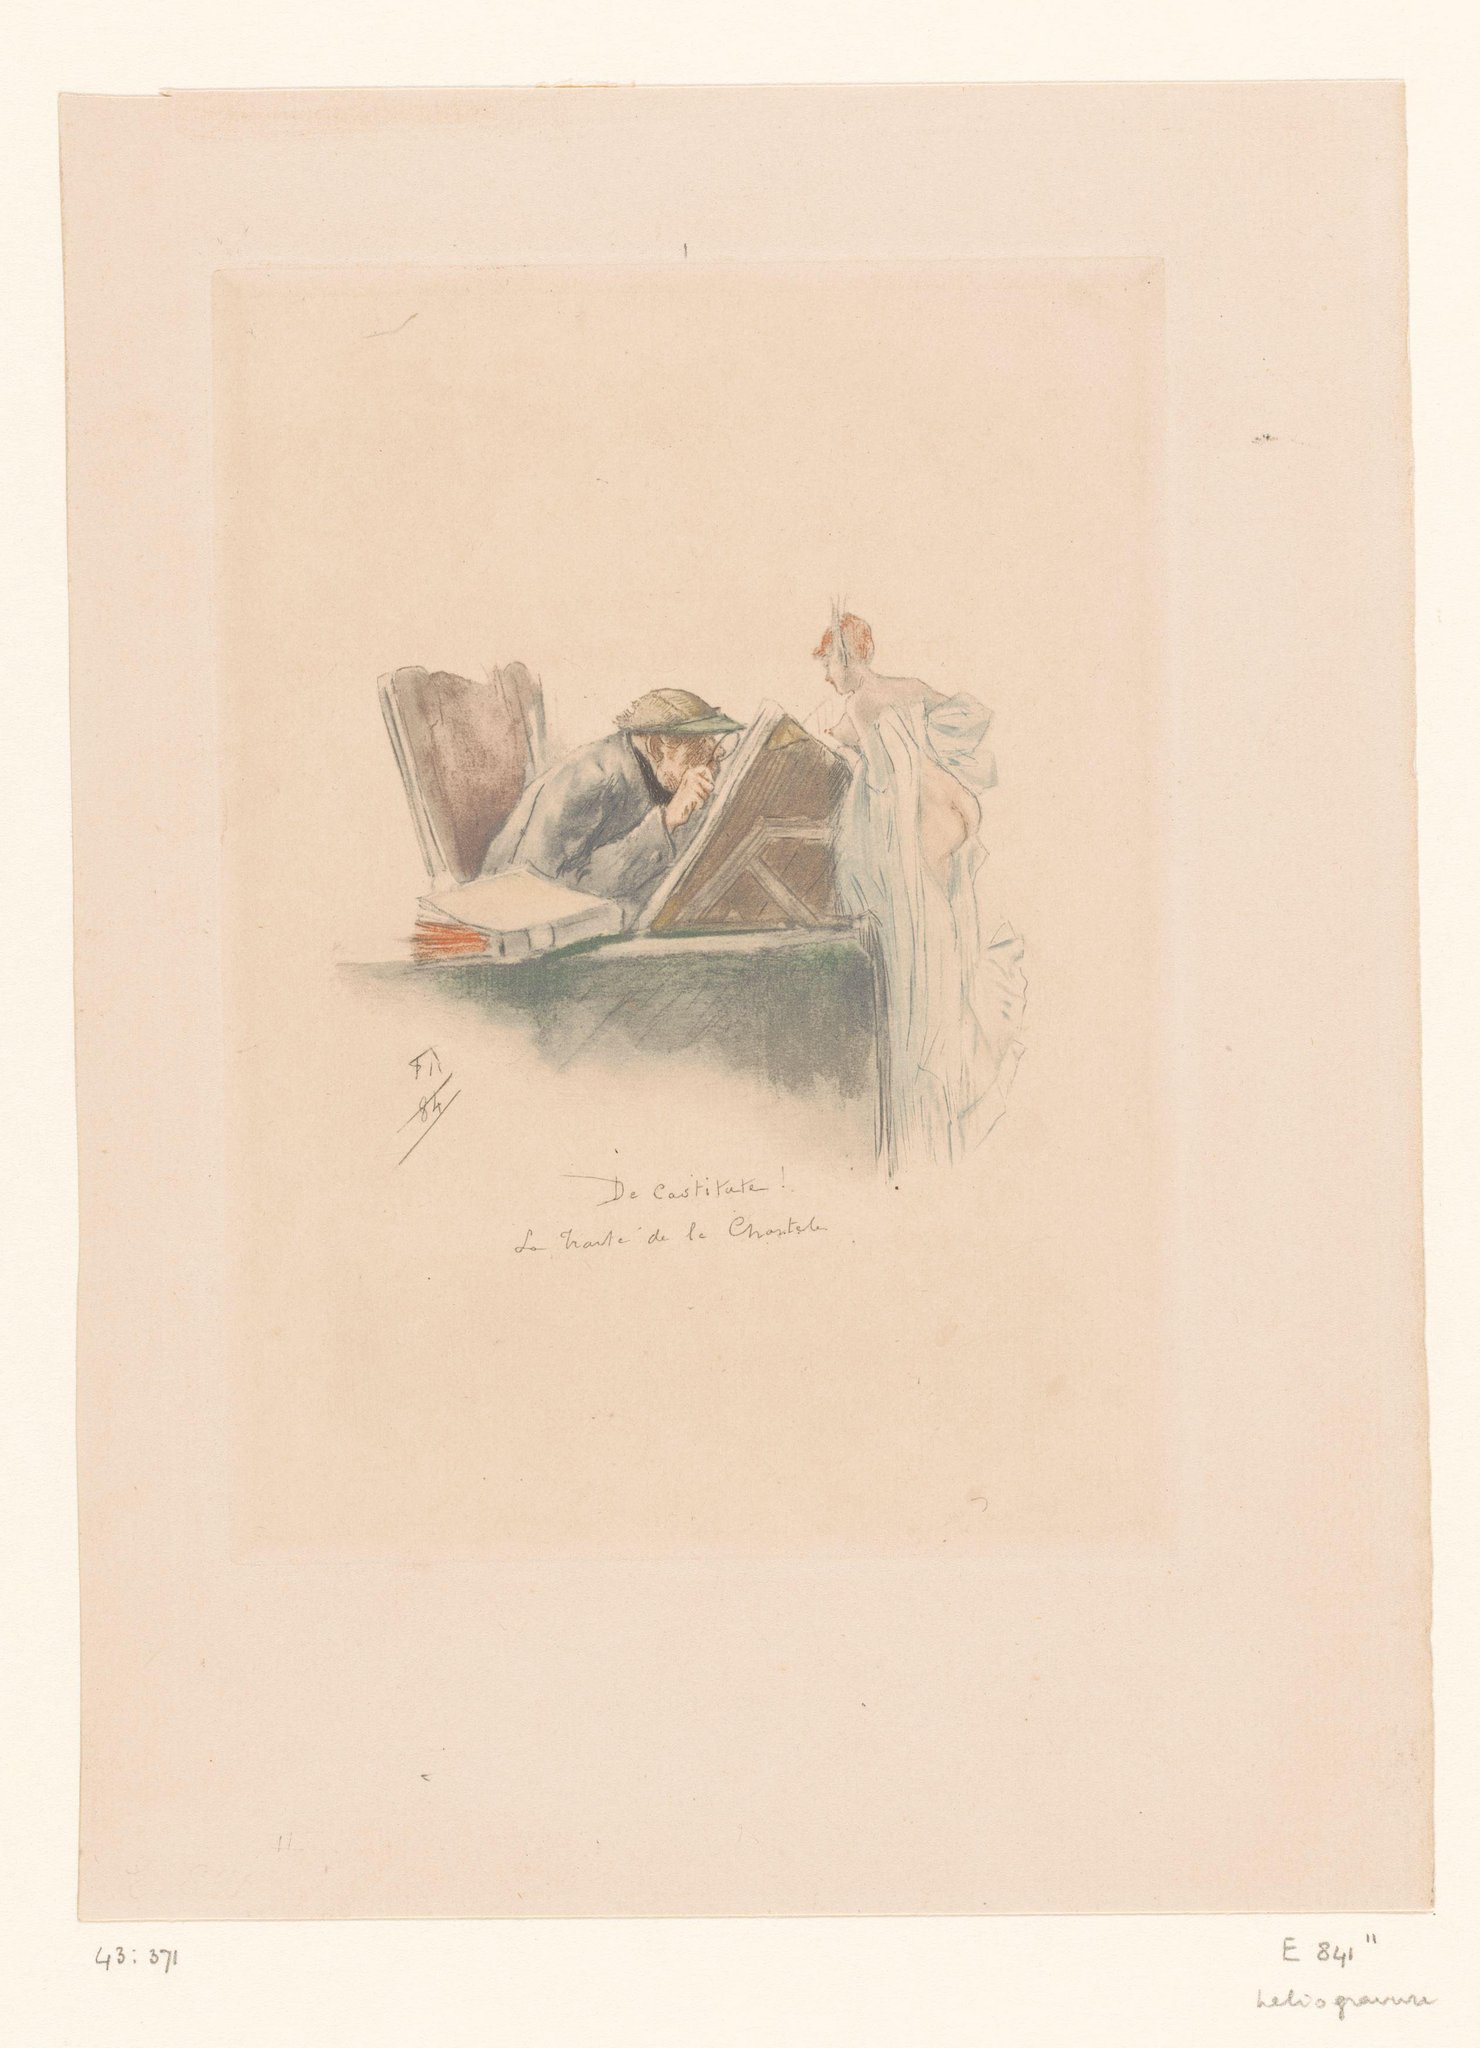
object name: print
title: Naakte vrouw leunt over het boek van een door een vergrootglas lezende oude man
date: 1884-1895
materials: paper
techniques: drypoint, photoaquatint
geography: paris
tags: reading, woman (showing herself) undressed, quasi-nude, magnifying glass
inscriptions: collector's mark: Lugt 2228, collector's mark: Lugt 2760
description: Prent uit: Ramiro, Erastène. Catalogue de l'oeuvre gravé de Félicien Rops. Parijs: Conquet, 1887.